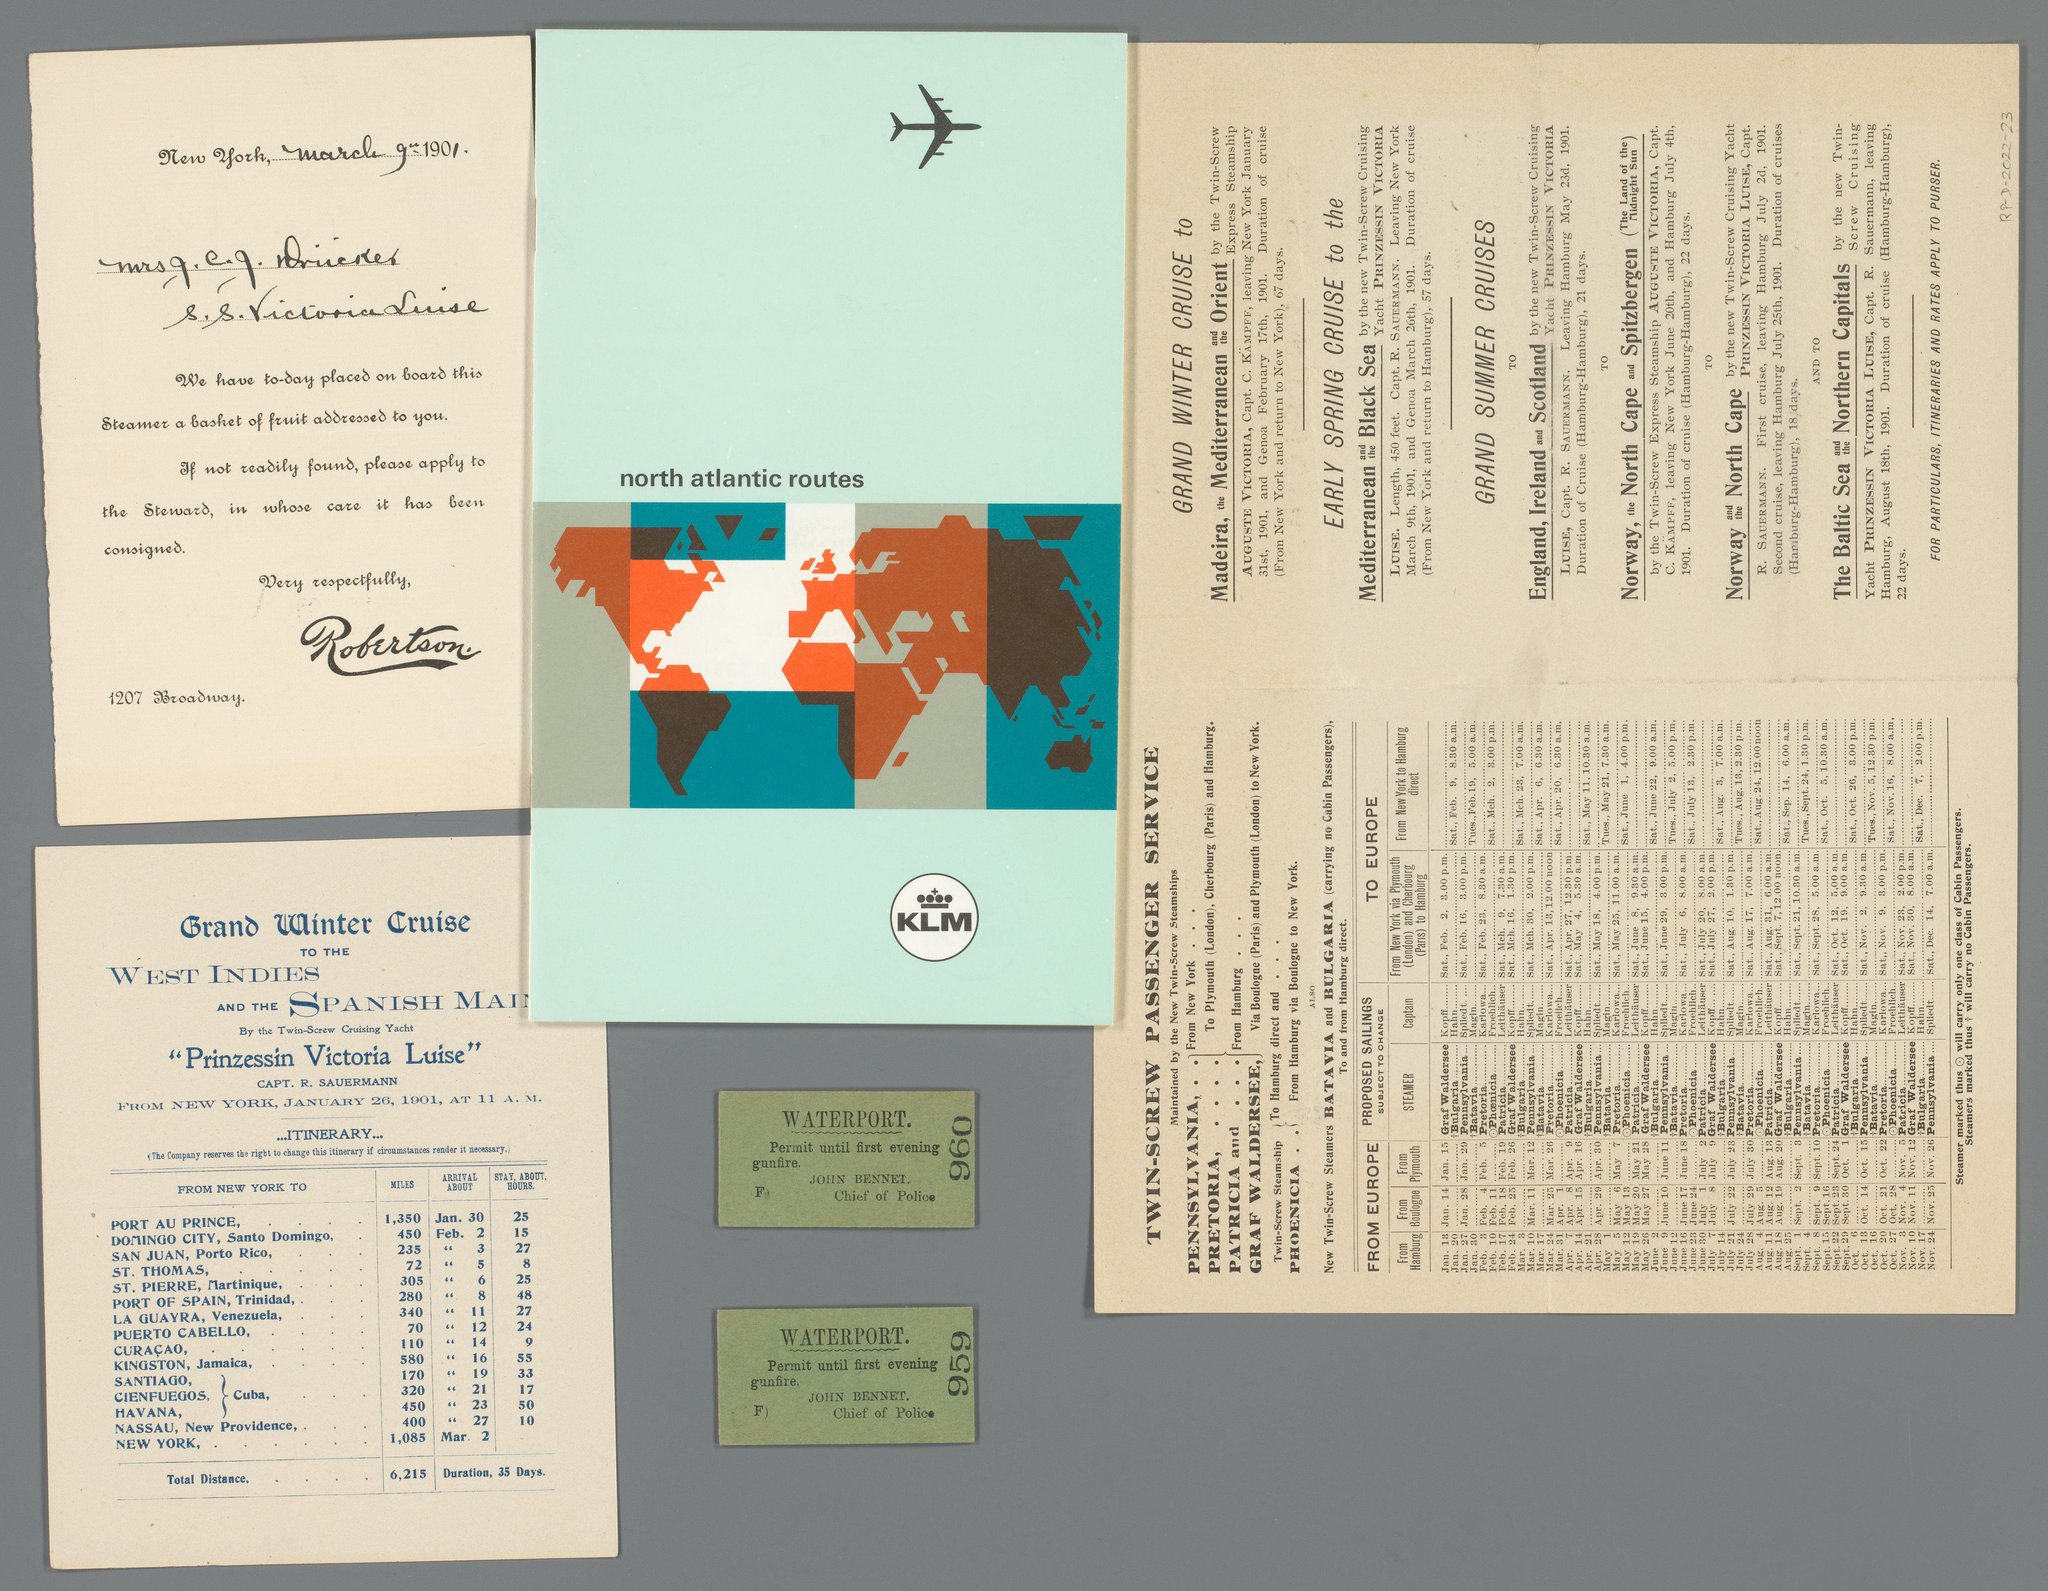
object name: text sheet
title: Documenten betreffende lucht- en zeevaart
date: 1901-1967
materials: paper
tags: advertising, aircraft, aeroplane, passenger liner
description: Cluster van 6 bladen met reisschema's, boekje met vluchtinformatie van de KLM, twee kaartjes voor bezoek aan de haven en de passagierslijst voor een cruise.